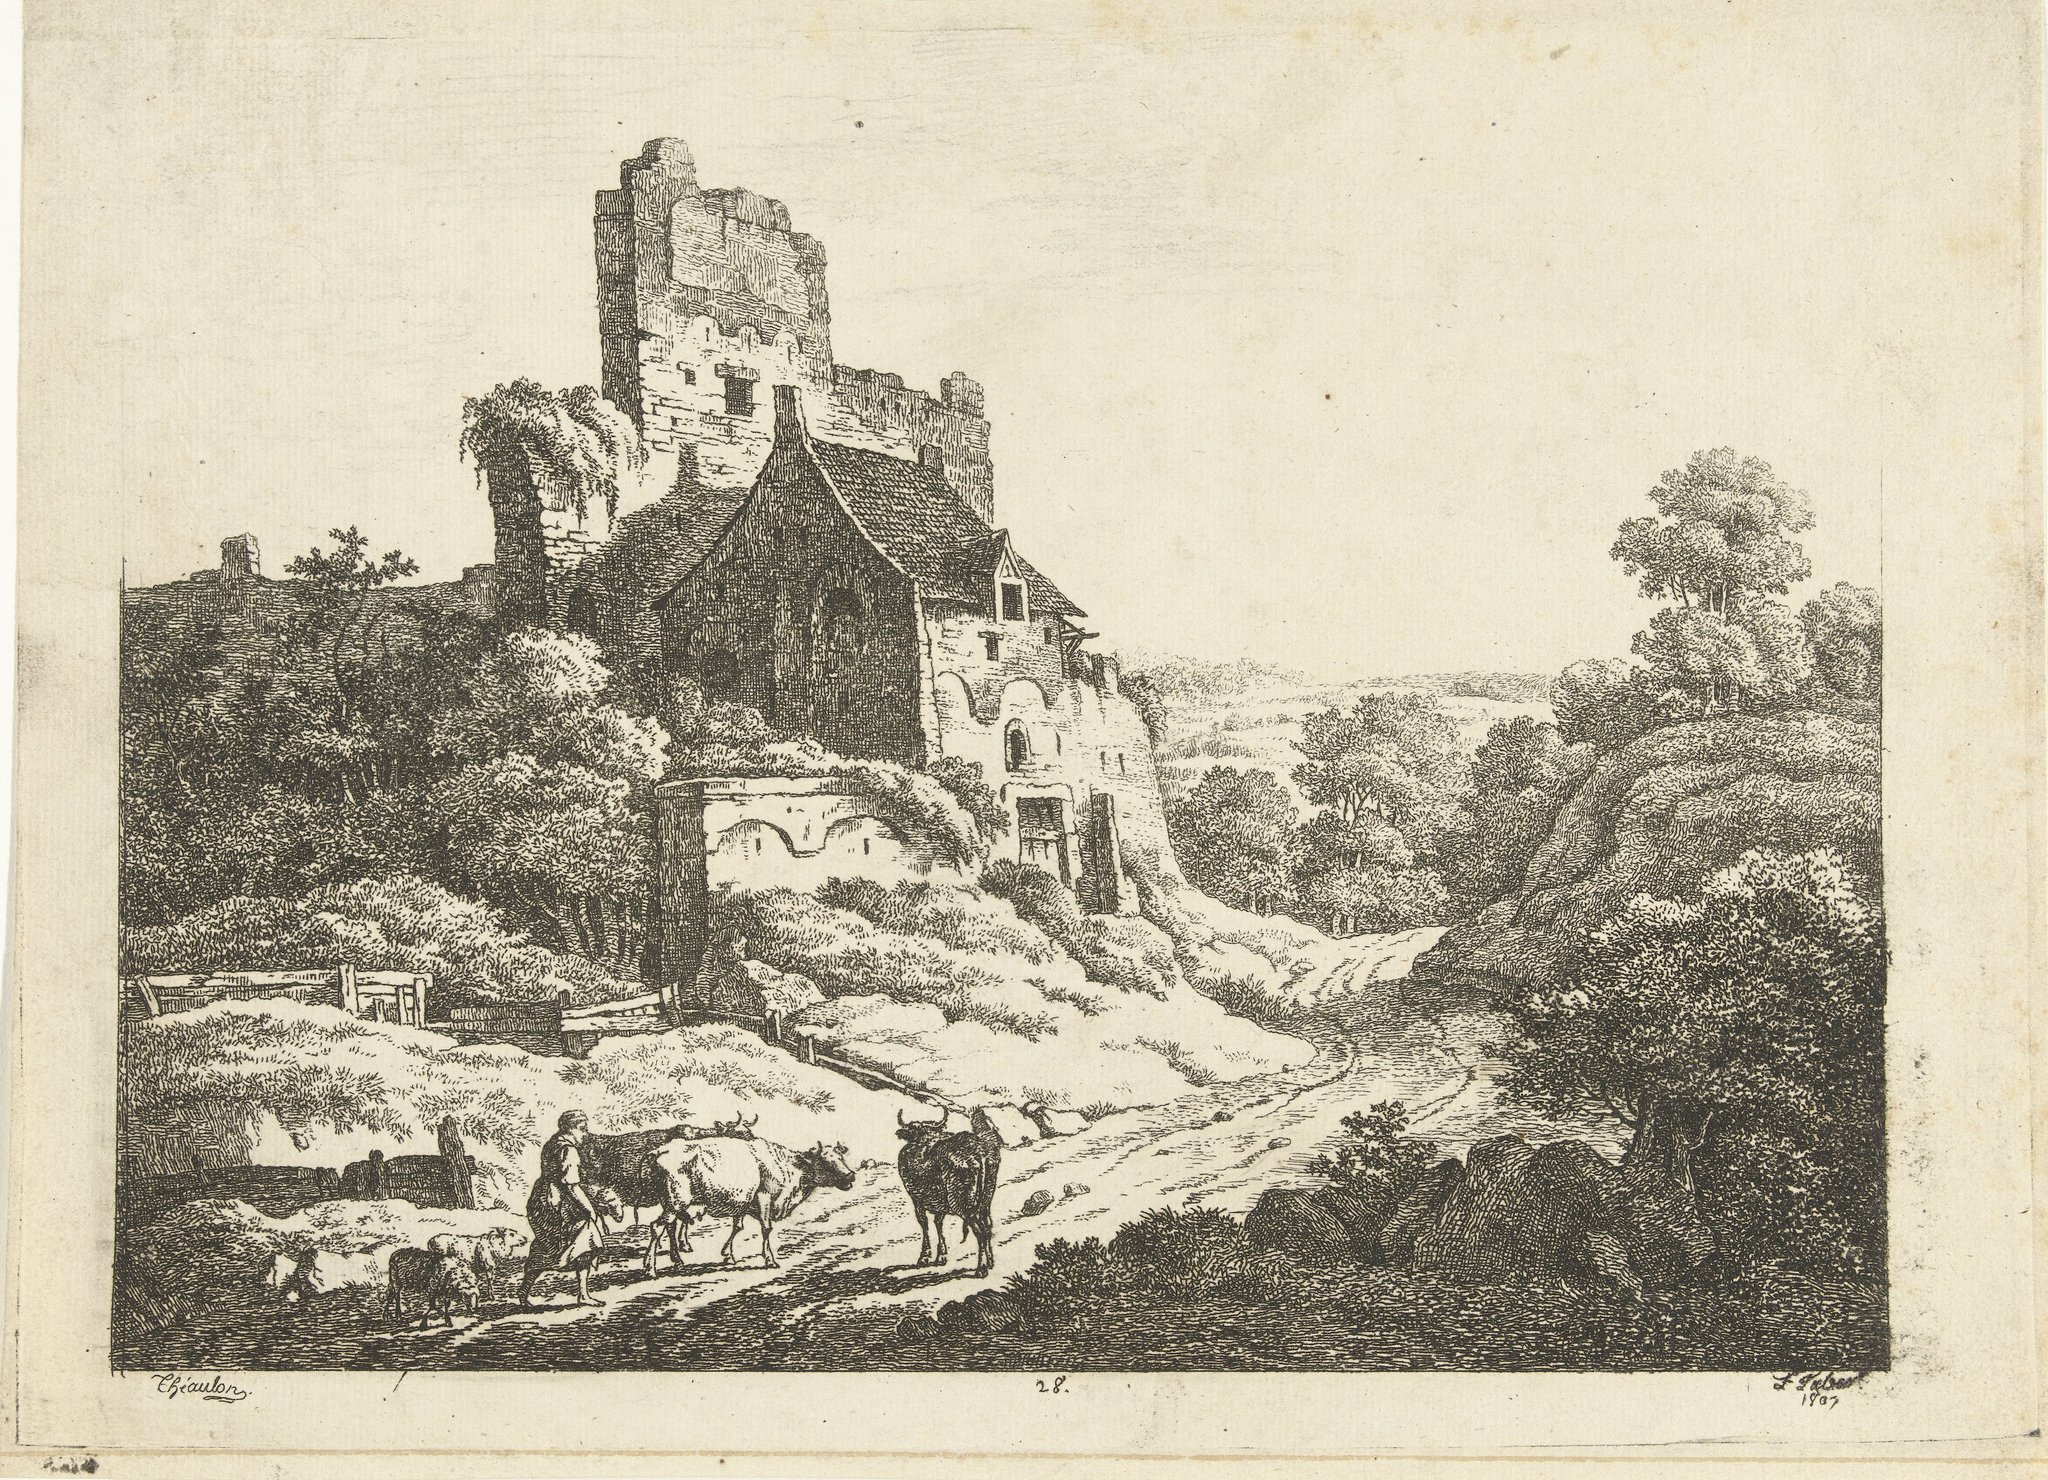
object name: print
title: Herderin bij ruïne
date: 1807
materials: paper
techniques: etching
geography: brussels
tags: herding, herdsman, herdswoman, shepherd, shepherdess, cowherd, etc.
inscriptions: collector's mark: Lugt 2228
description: Glooiend landschap met op de voorgrond een herderin met drie koeien en schapen. Langs het pad een huis met daarachter een ruïne.